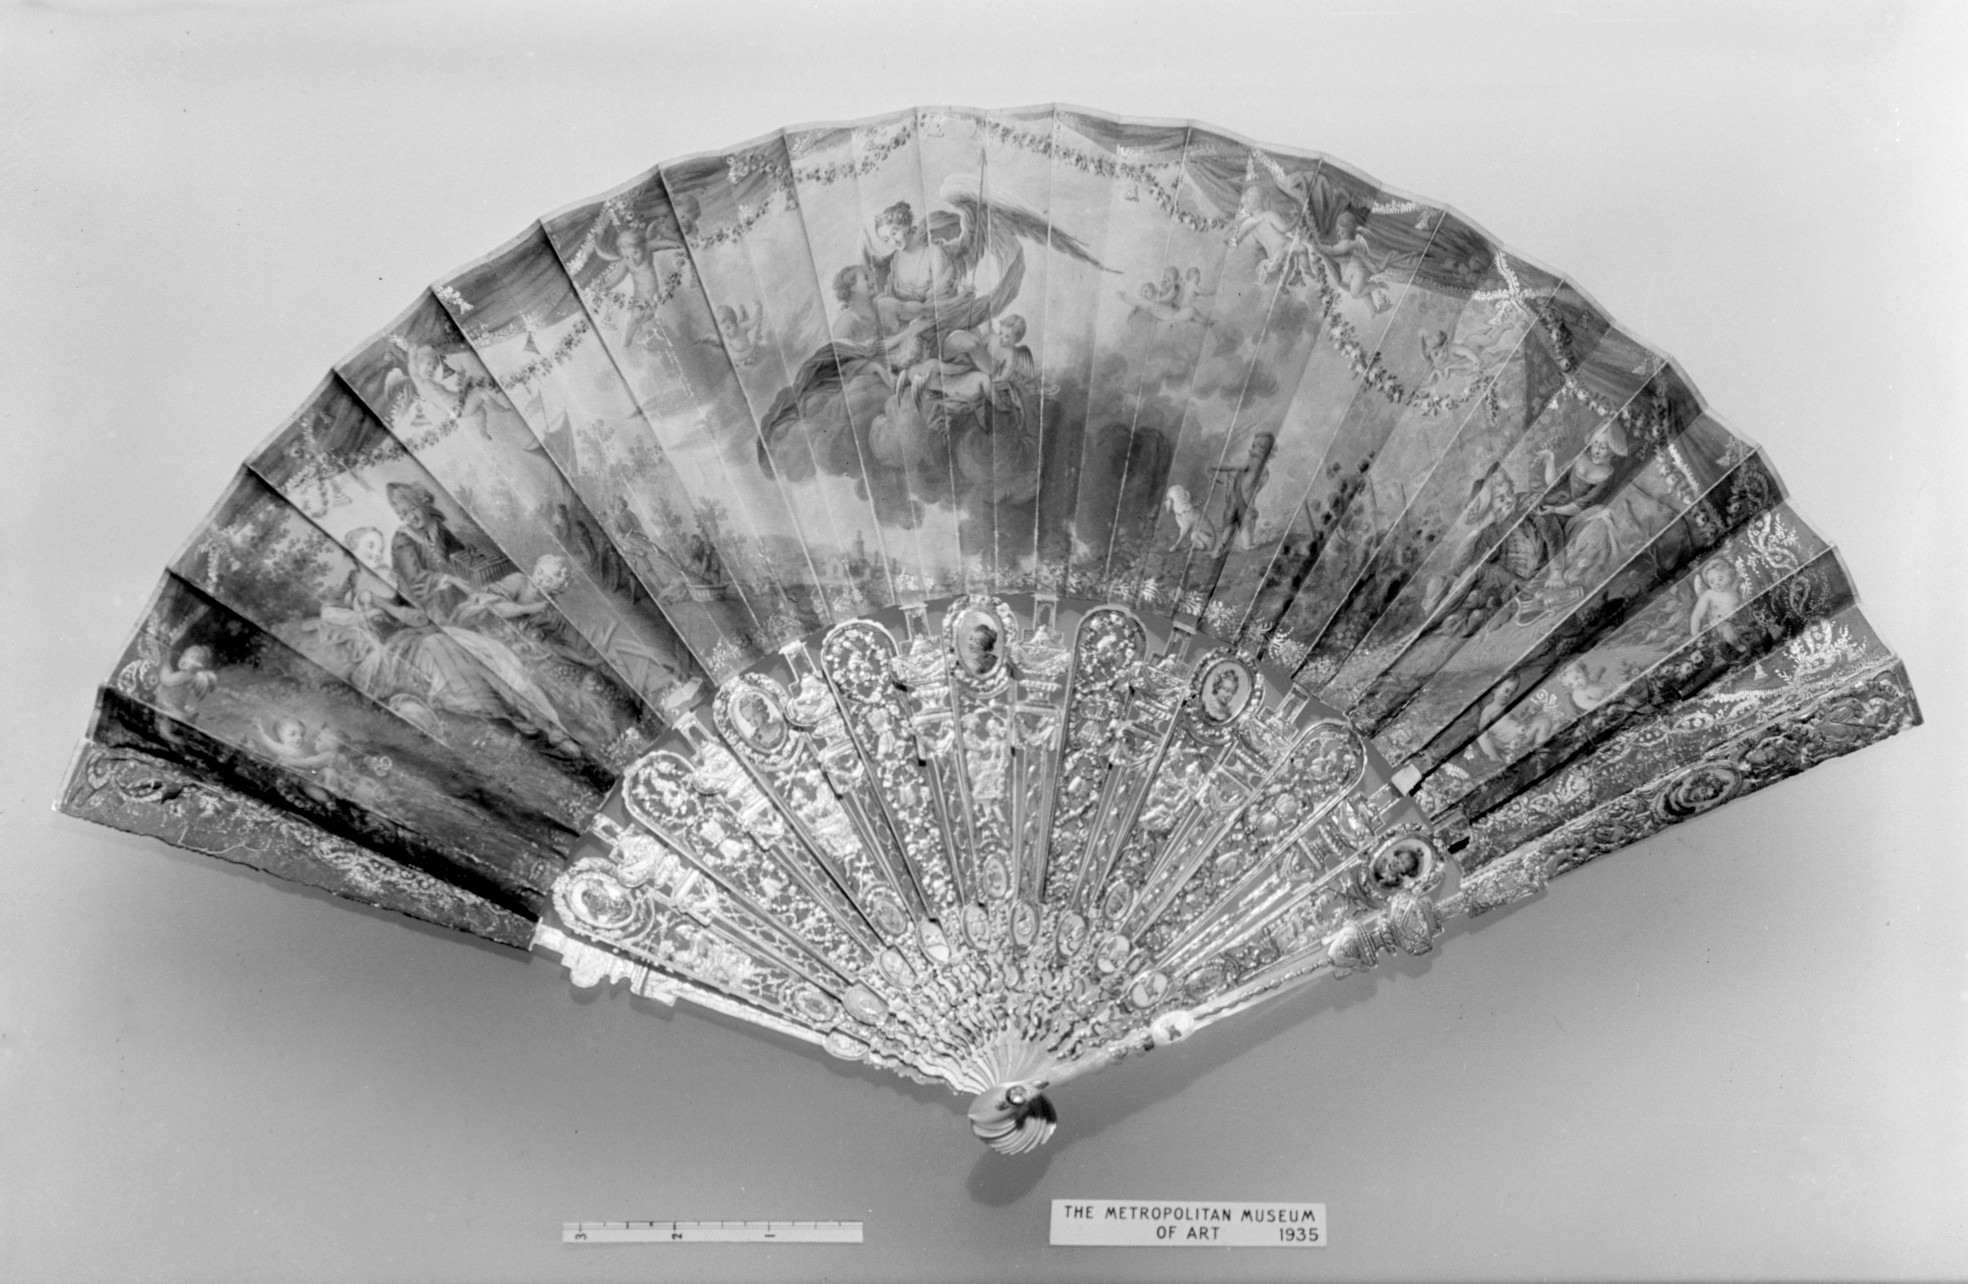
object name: fan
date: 1776-1800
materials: gold leaf, mother of pearl, paper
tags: men,women